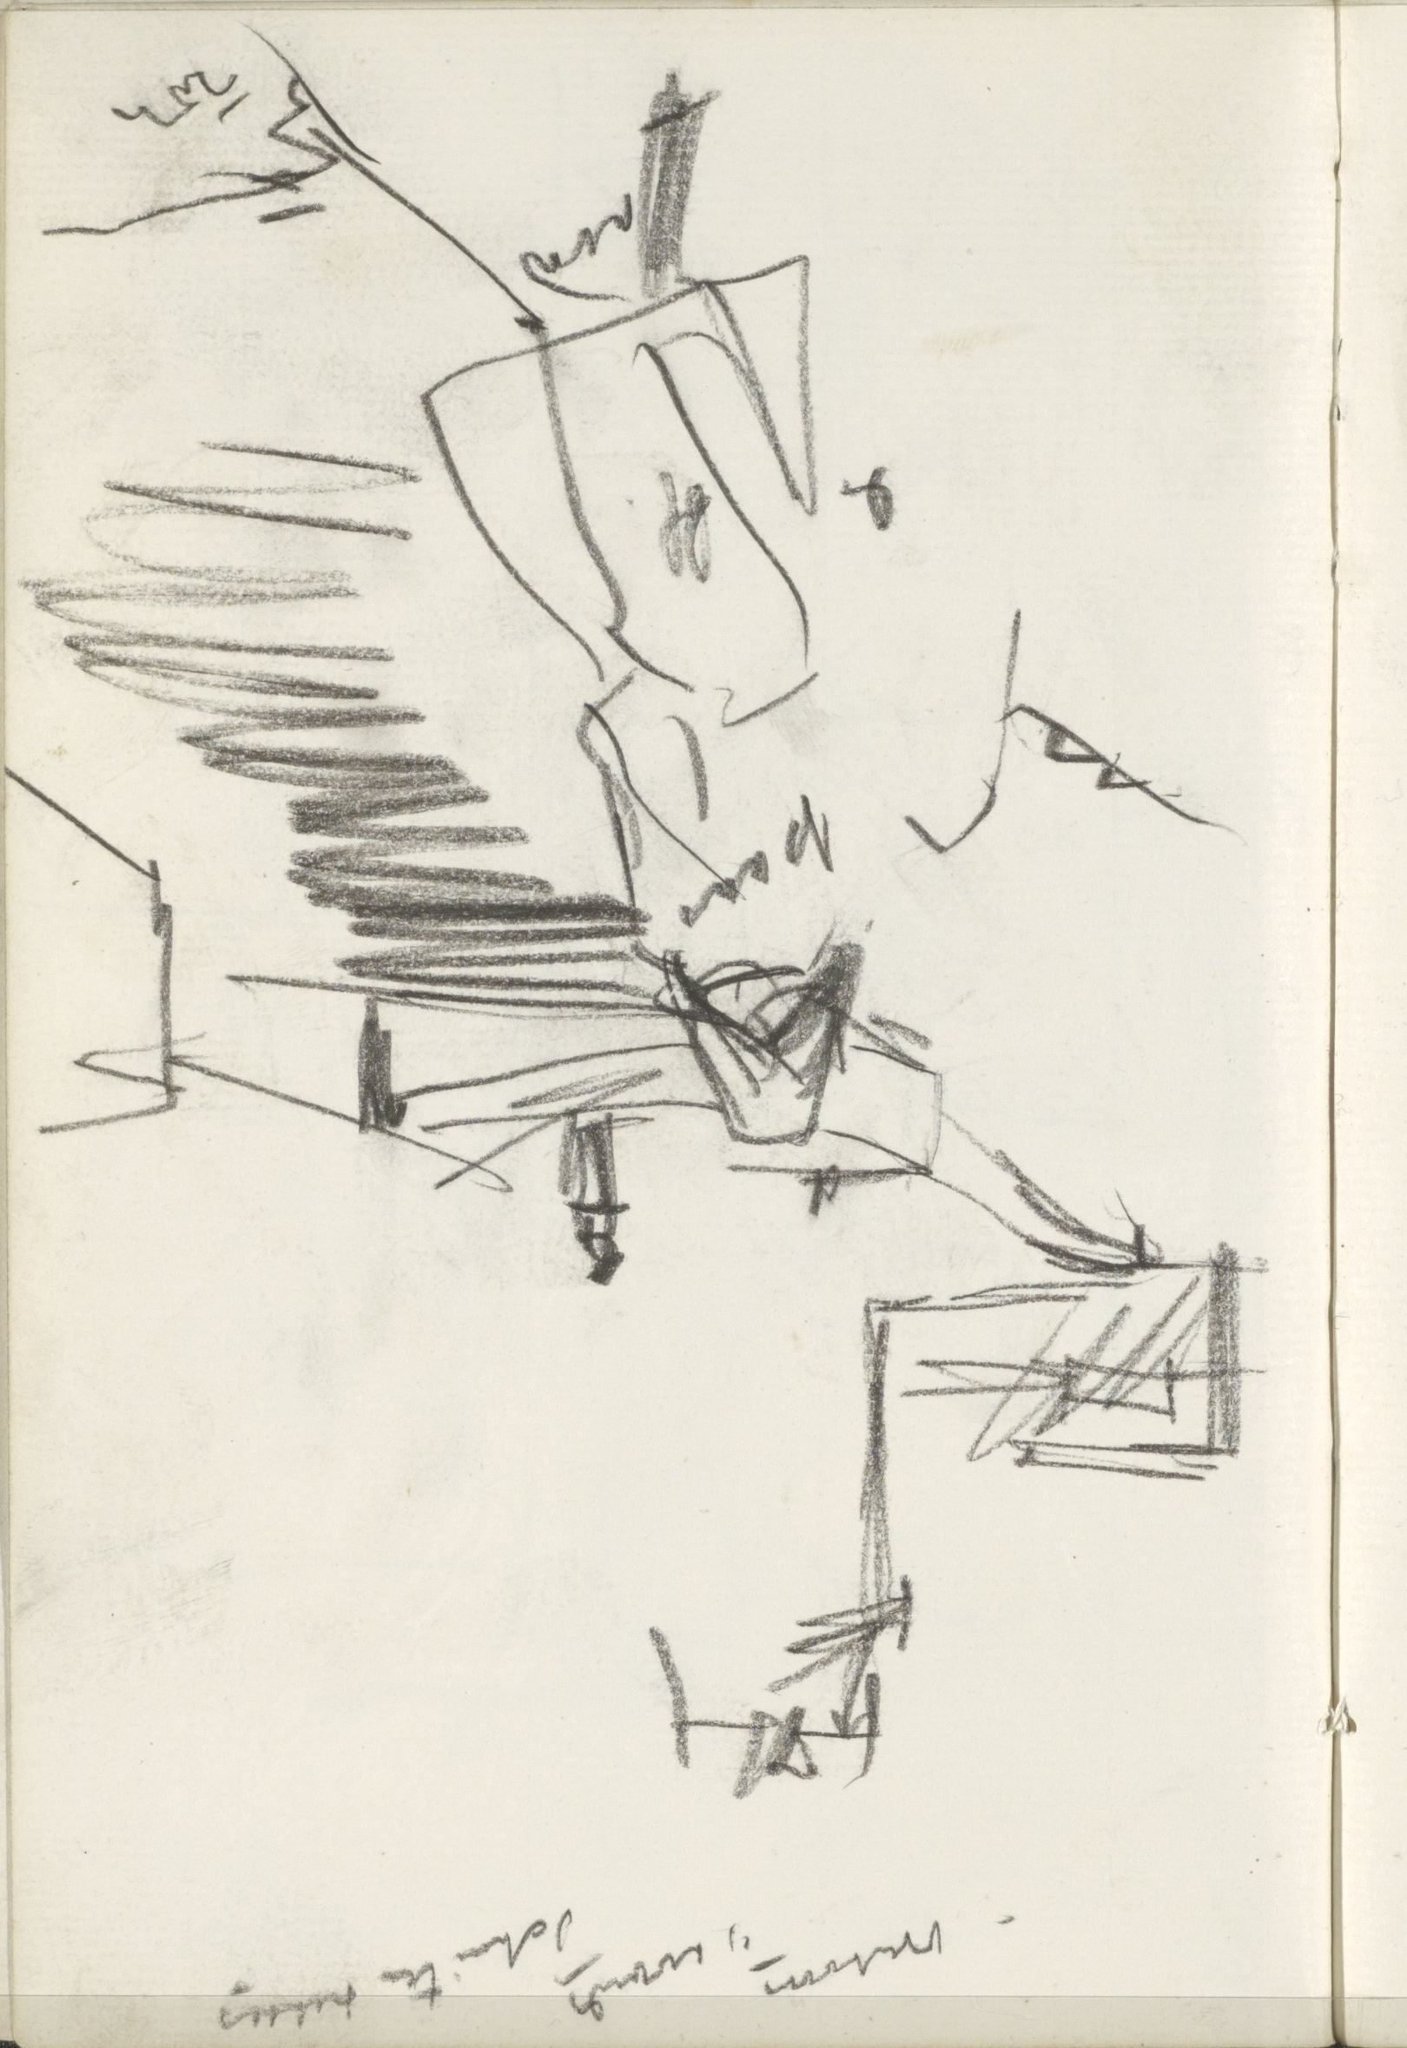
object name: sketchbook leaf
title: Jonge vrouw op de Overtoom te Amsterdam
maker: george hendrik breitner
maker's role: draughtsman, painter, print maker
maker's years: 1857-1923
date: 1895-1898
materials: chalk, paper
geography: amsterdam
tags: adolescent, young woman, maiden, ships (in general), canals, waters (in city) (+ city(-scape) with figures, staffage)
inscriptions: annotation: ‘Overtoom/ 's avonds/ schuiten/ [...]’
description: In het water ligt een schuit. Pagina 31 uit een schetsboek met 20 bladen.